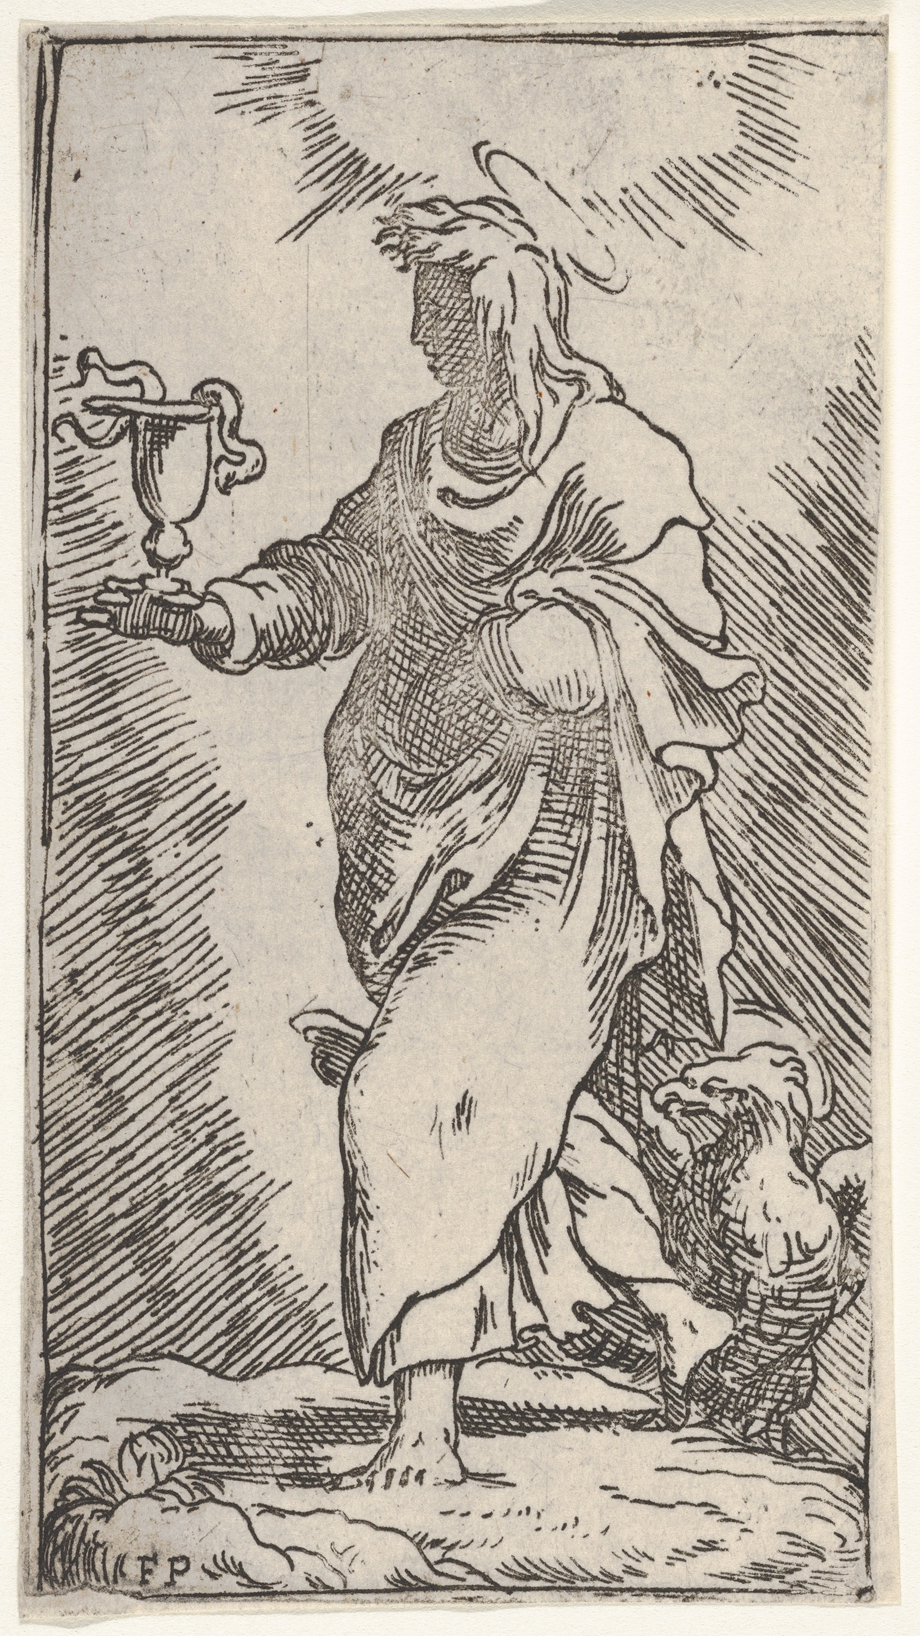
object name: print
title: St. John the Evangelist, striding in three-quarter view toward the left and holding a chalice with snakes in his right hand, an eagle stands behind his right leg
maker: master f. p.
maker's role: artist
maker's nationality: italian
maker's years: 1500-1600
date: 1501-1600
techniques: etching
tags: eagles,snakes,saint john the evangelist,chalices